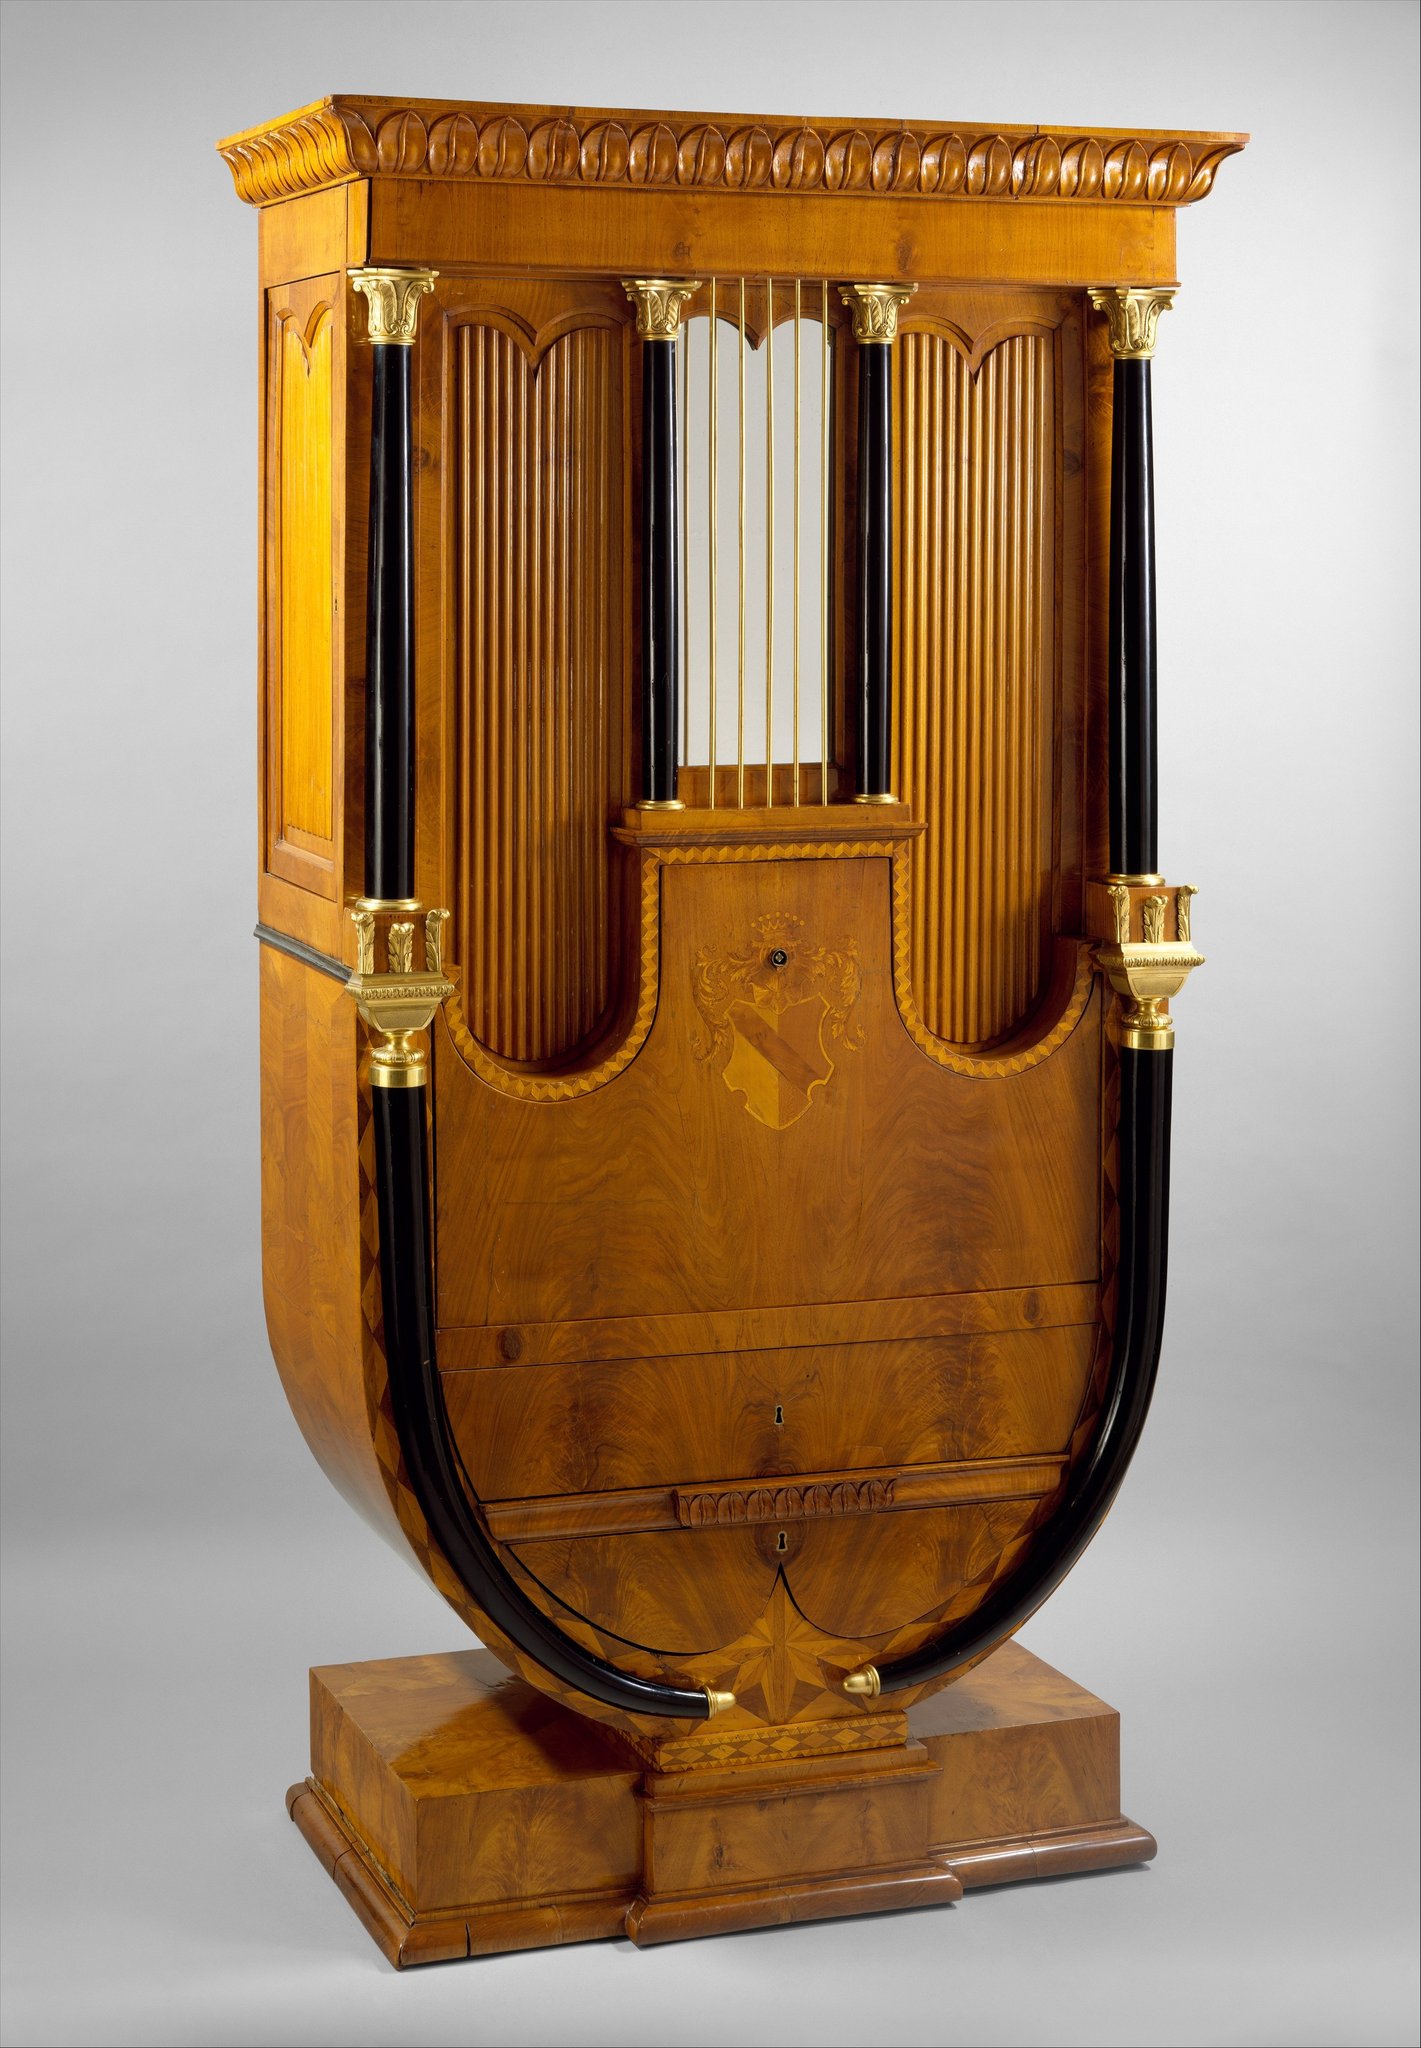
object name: secretary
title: Secretary (sécretaire à abattant)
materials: brass, gilt bronze, glass, leather, wood